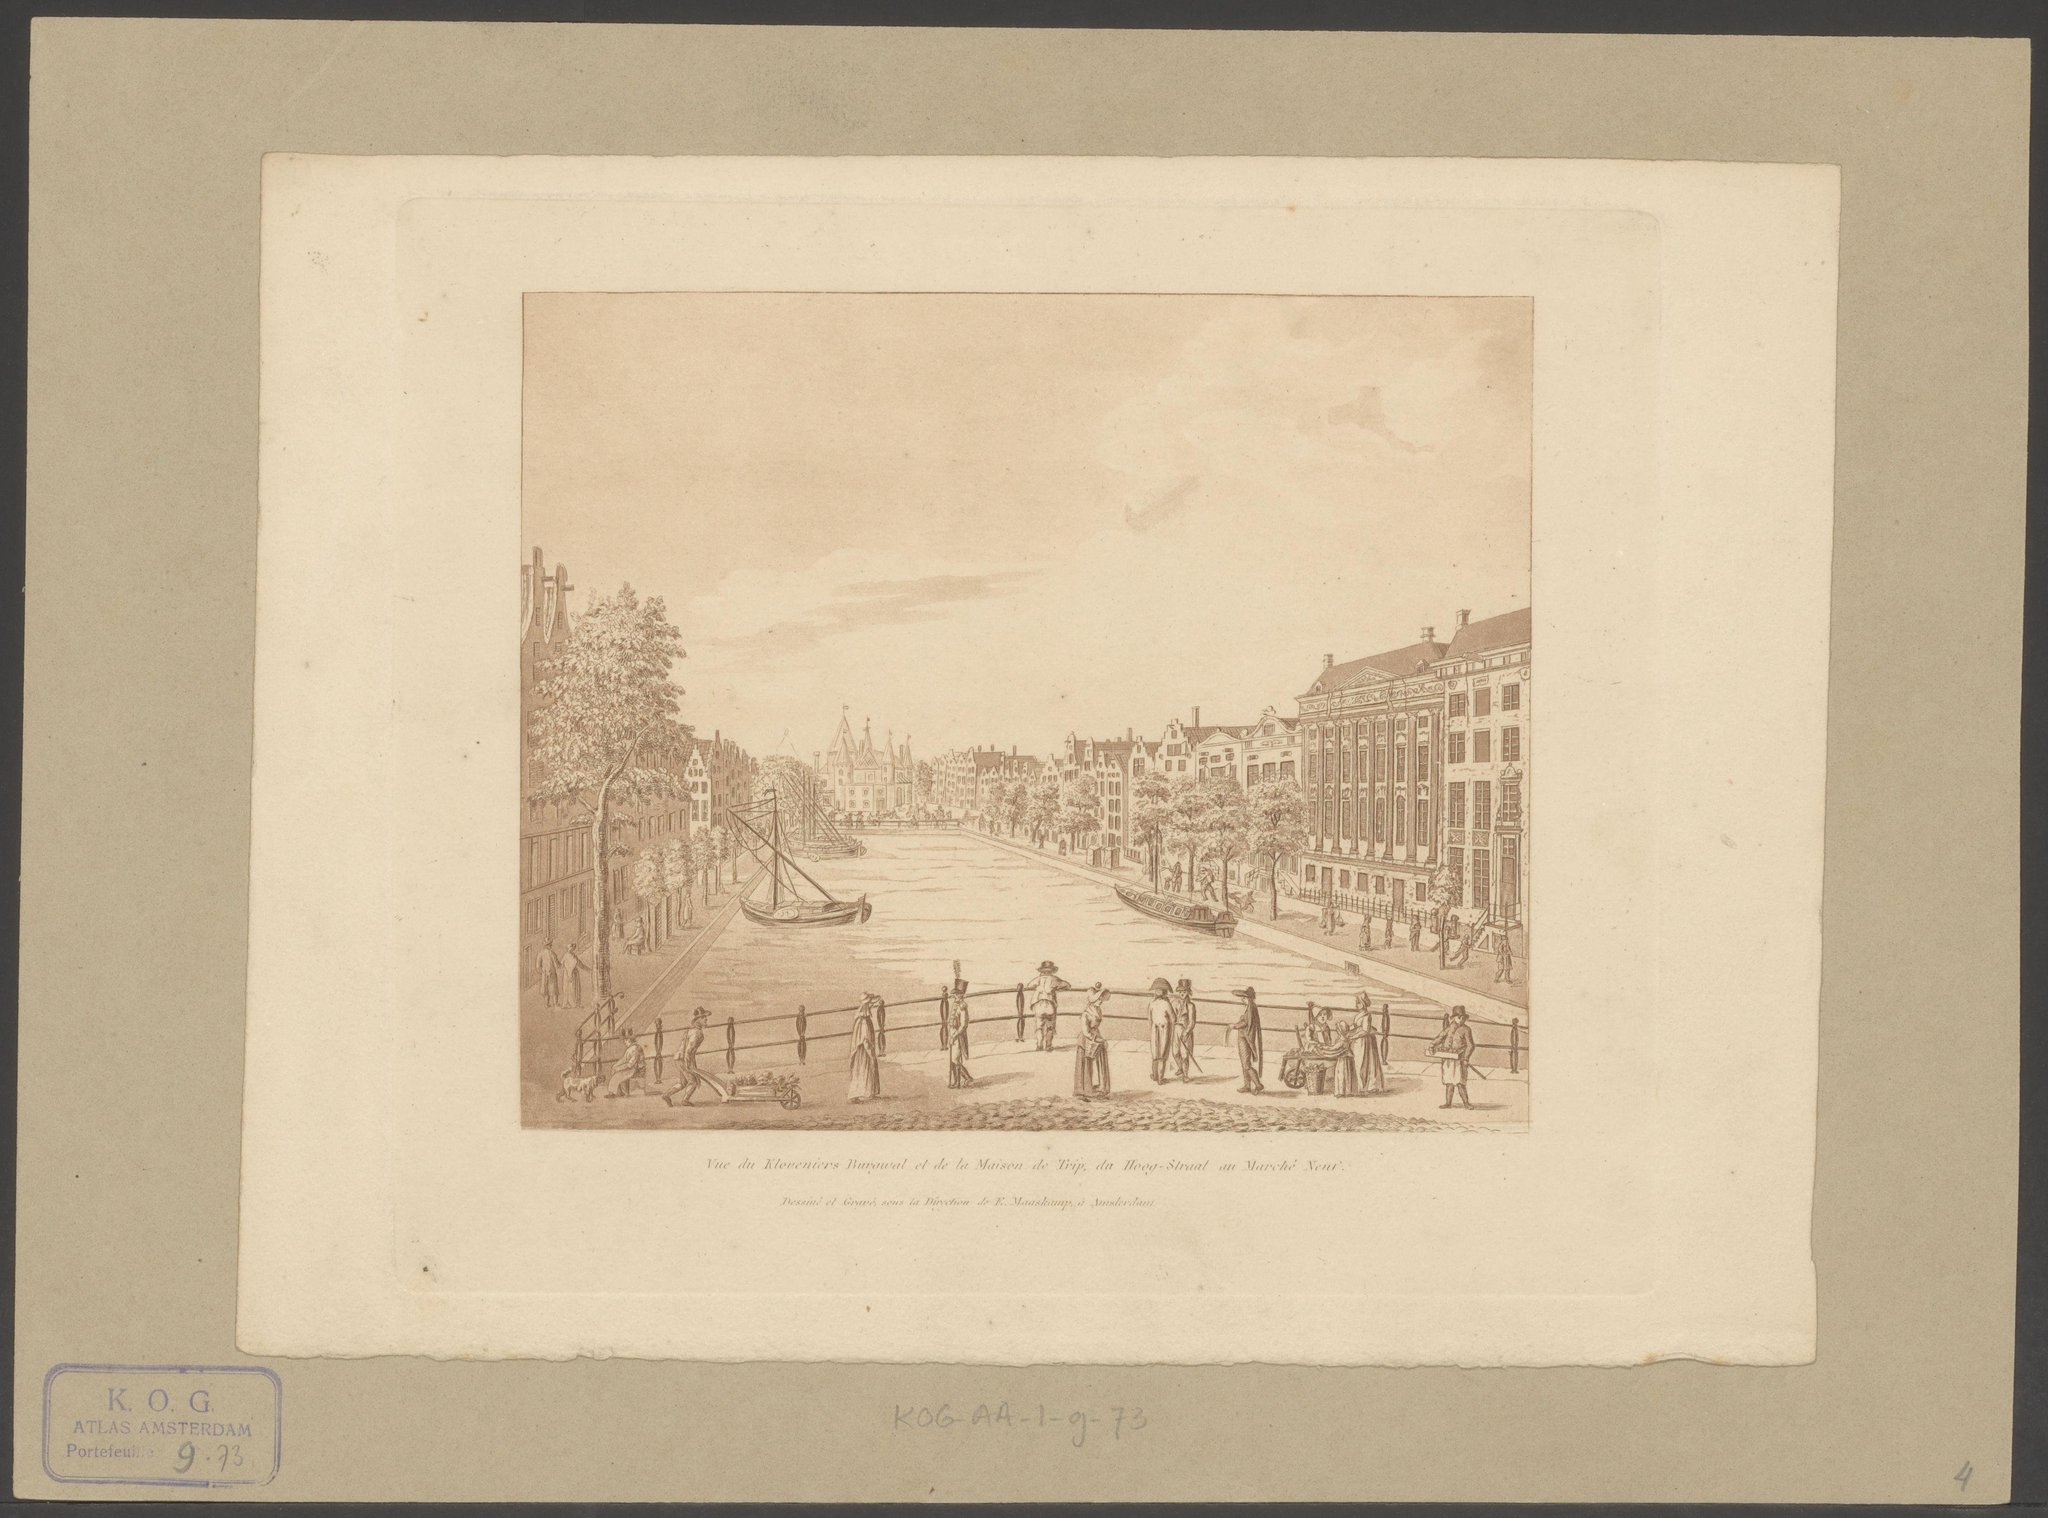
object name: print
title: Vue du Kloveniers Burgwal et de la Maison de Trip, du Hoog-straat au Marché Neuf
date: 1810-1813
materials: paper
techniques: aquatint, engraving, etching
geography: amsterdam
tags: sailing-ship, sailing-boat, city-view in general; 'veduta', canal, bridge in city across river, canal, etc., weigh-house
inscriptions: collector's mark: ‘9.73’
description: Onderwerpsrubriek binnen de Atlas Amsterdam: Kadijksplein, Karthuizerkerkhof, Kattegat, Kattenburg, Kapelsteeg O.Z., Enge Kerksteeg, Kerkstraat, Kinkerstraat, Kolk O.Z., Koningsplein, Kromboomsloot [Krom Boomssloot], Kostverlorenkade, Kwakersdwarspad, Kalverstraat, Keizersgracht (v.d. Brouwersgracht – Amstel), Klerensloot (Gedempte), Klimopstraat, Kloveniersburgwal, Kraansluis.